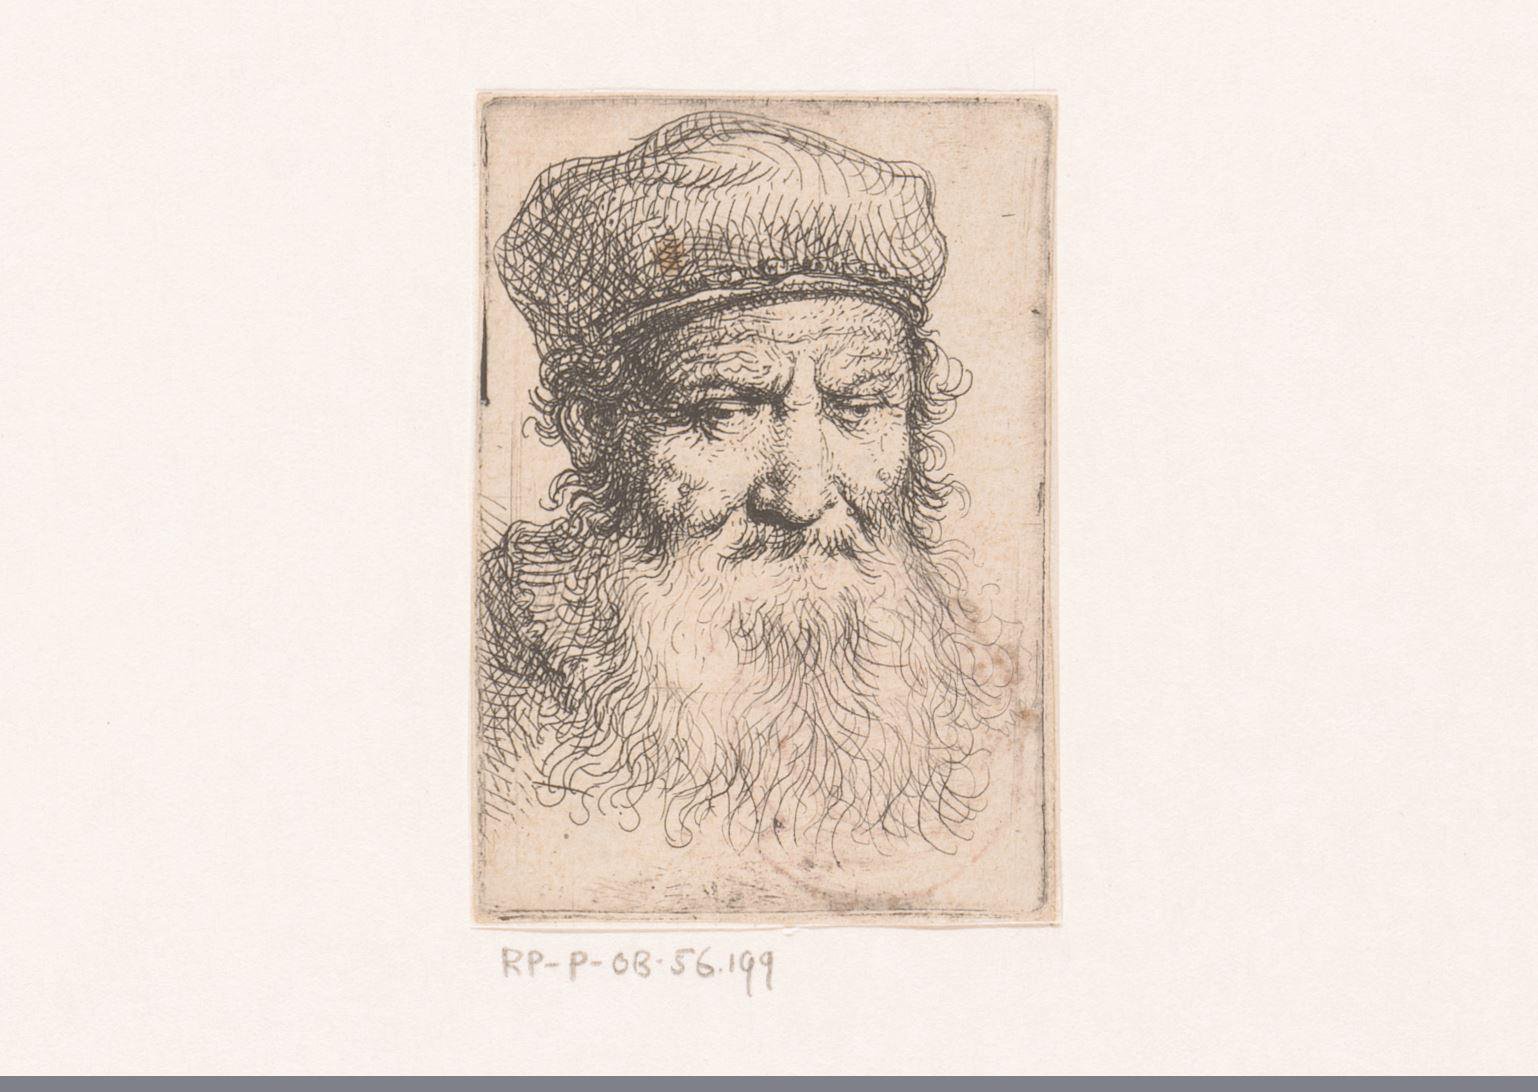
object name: print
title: Oude man met baard en muts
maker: michael willmann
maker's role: draughtsman, print maker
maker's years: 1630-1706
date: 1640-1706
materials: paper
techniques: etching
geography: germany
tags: old man, head-gear: cap, beard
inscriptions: collector's mark: Lugt 240